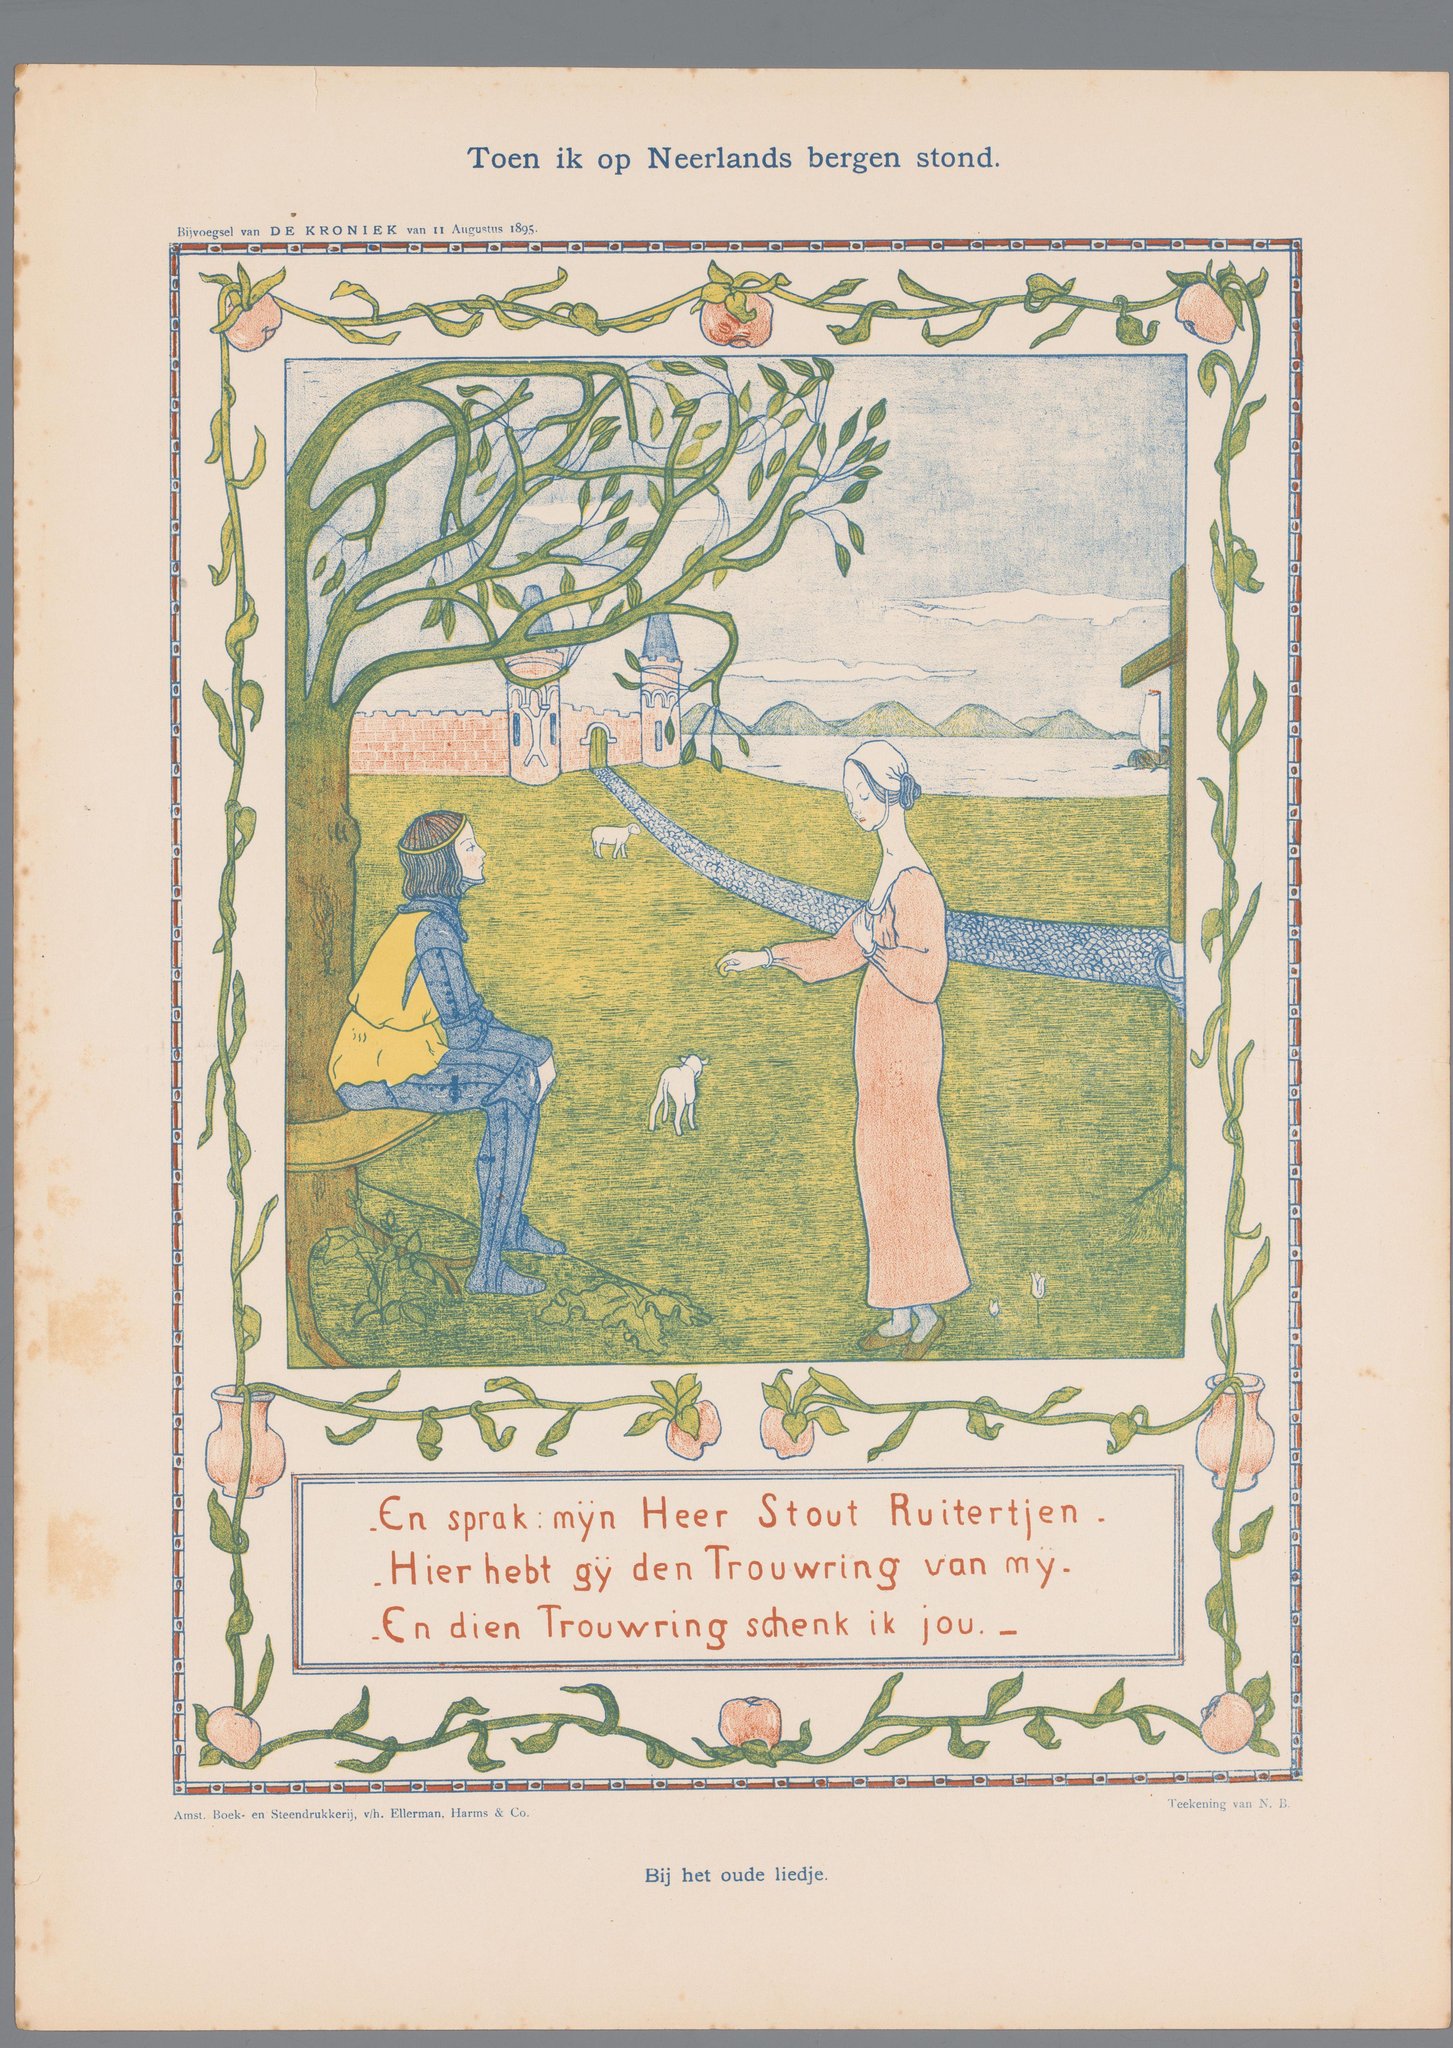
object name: print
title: Toen ik op Neerlands bergen stond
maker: nelly bodenheim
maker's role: designer, draughtsman, print maker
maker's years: 1874-1951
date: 1895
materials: paper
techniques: lithograph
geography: amsterdam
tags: wedding ring, landscape with tower or castle, lamb, proposal, declaration of love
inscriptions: date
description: Een staande vrouw biedt een trouwring aan aan een man in harnas die op een bank bij een boom zit. Op de achtergrond twee lammeren, de ommuring van een kasteel en een zeilboot in het water. Om het tafereel plantmotieven en eronder de tekst: 'En sprak: mijn heer stout ruitertjen. Hier hebt gij den trouwring van mij. En dien trouwring schenk ik jou'.